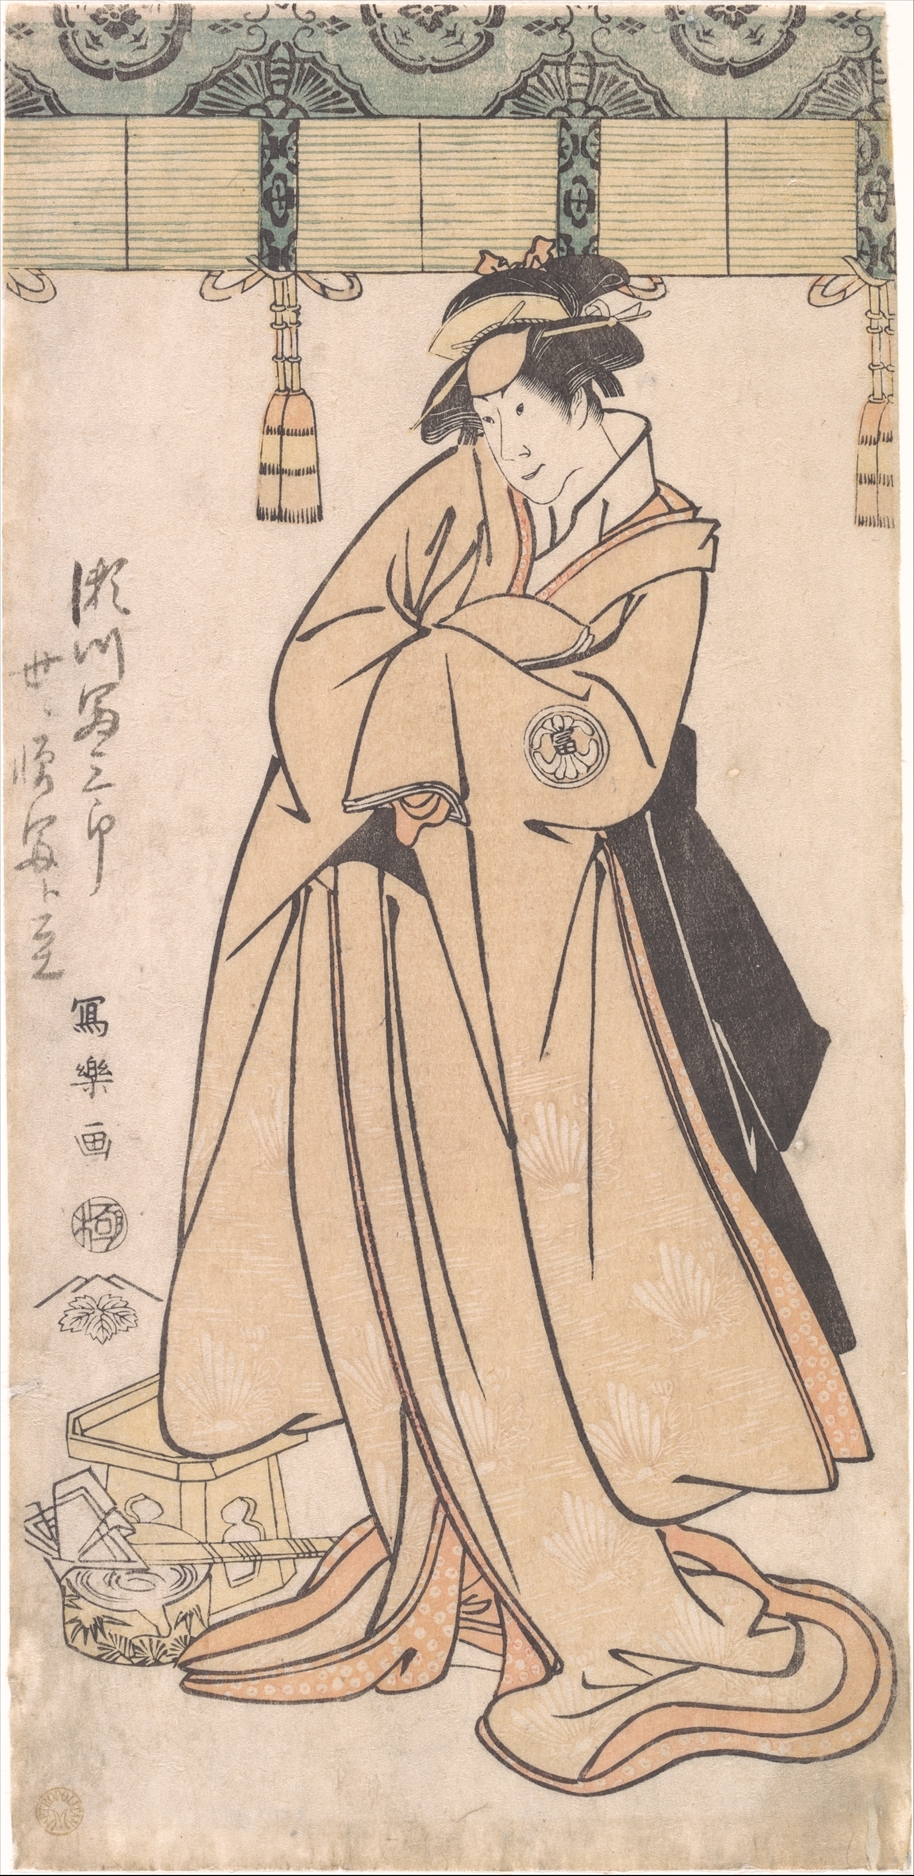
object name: print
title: The Actor Segawa Tomisaburo II as the Otomos' Maid Wakakusa, Actually Prince Korehito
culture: japanese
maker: tōshūsai sharaku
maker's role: artist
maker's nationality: japanese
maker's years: 1794-1795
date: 1775-1794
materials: ink, paper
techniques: woodblock print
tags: men,actors